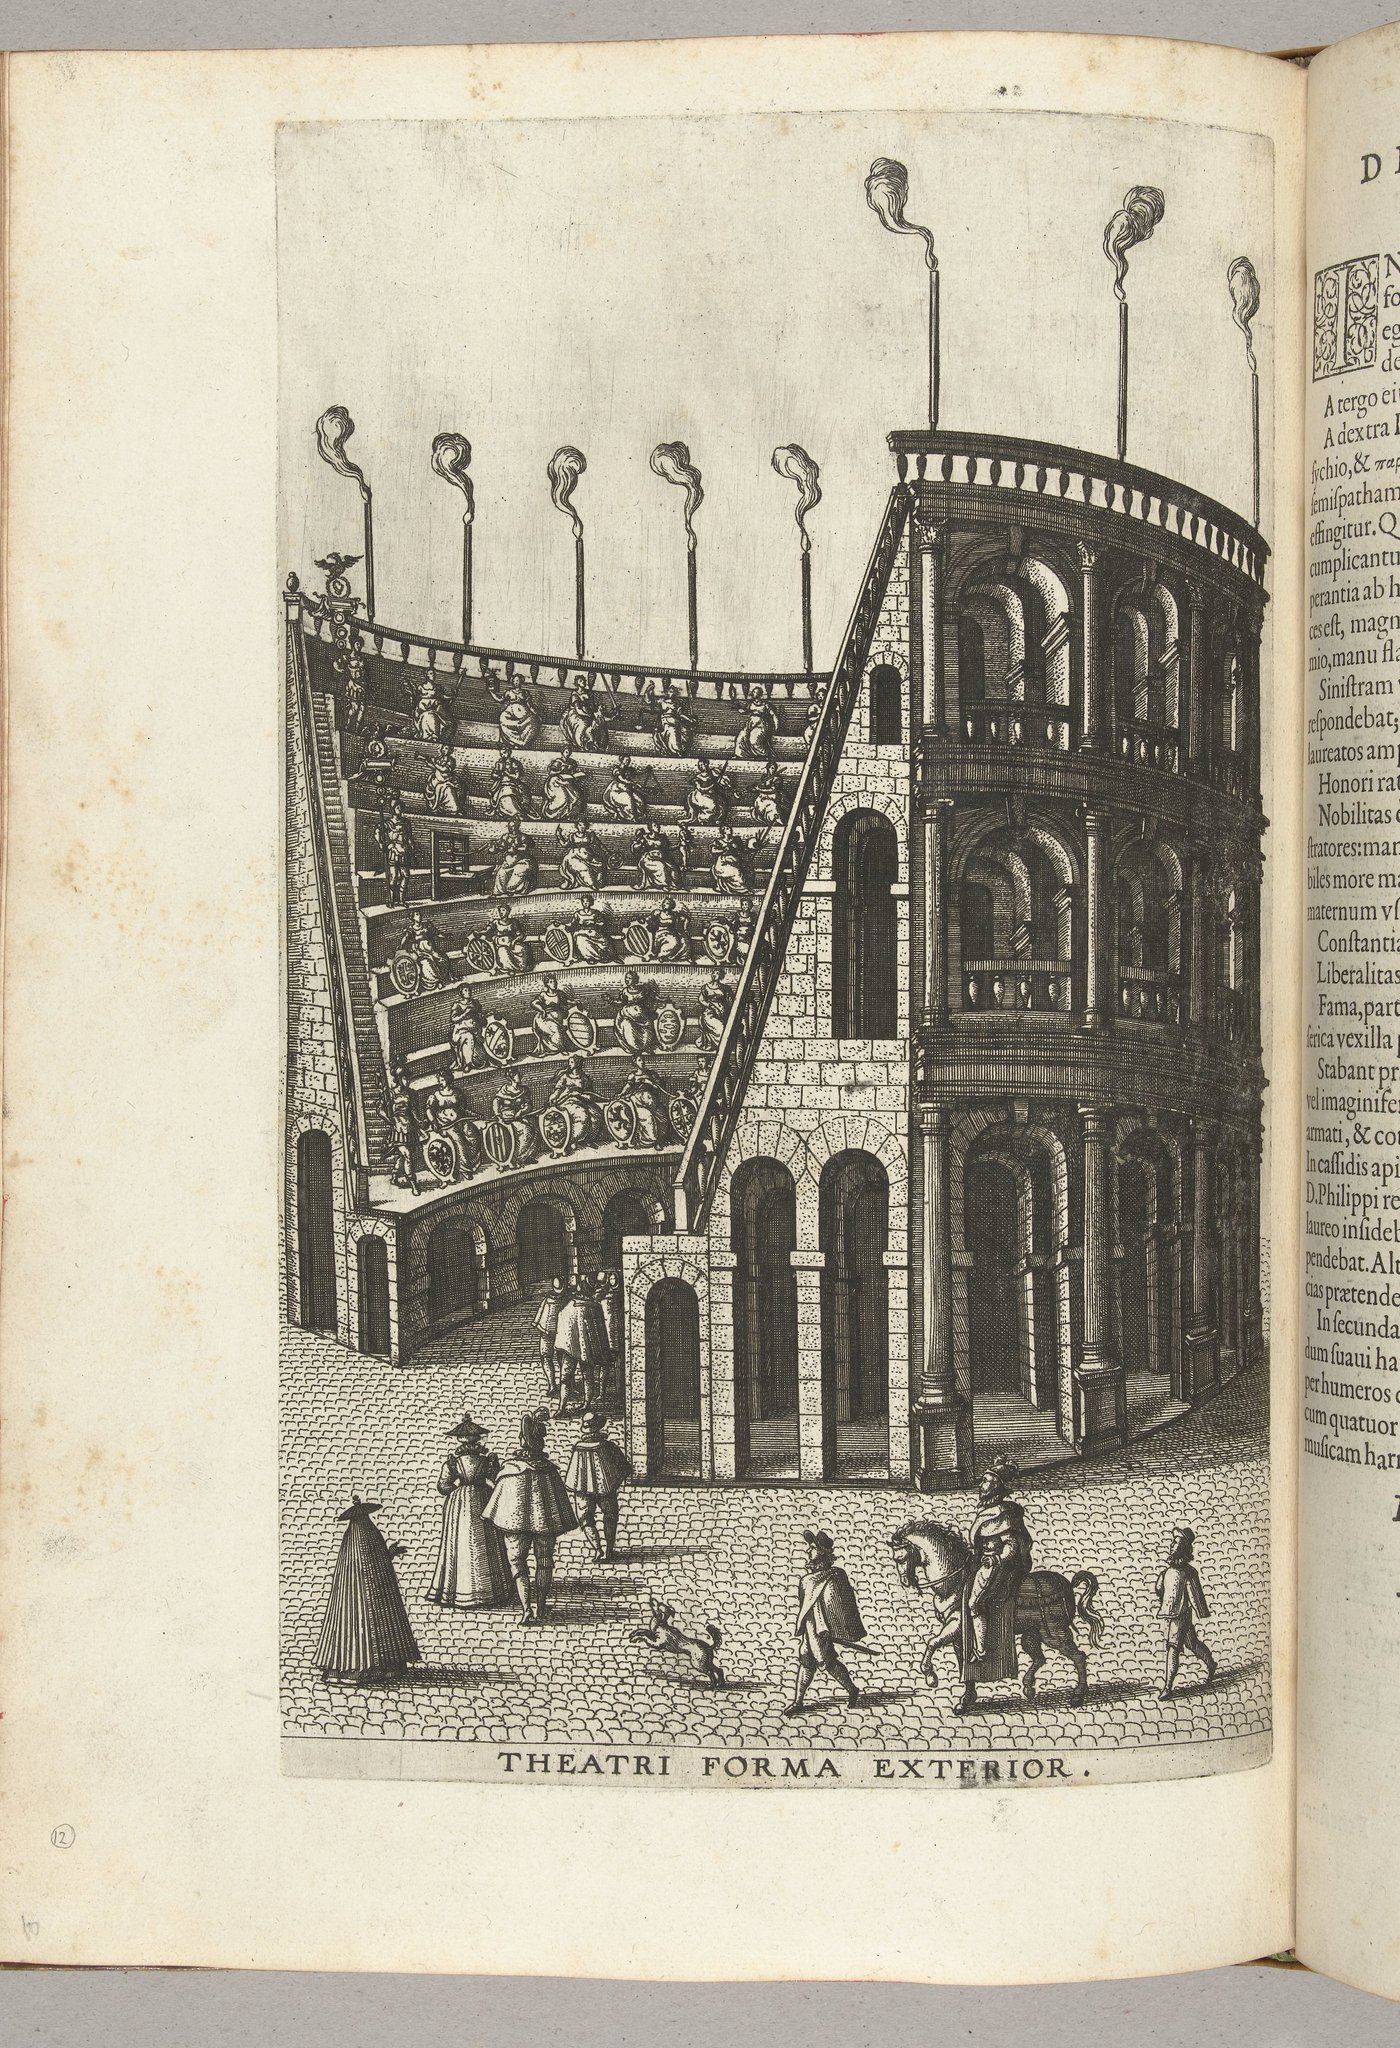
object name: print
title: Theatri Forma Exterior.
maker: pieter van der borcht (i)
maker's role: print maker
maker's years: 1545-1608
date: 1594-1595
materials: paper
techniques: etching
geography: antwerp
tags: brussels, triumphal entry and public reception, pageant, 'entrée solennelle', 'joyeuse entrée', antwerp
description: Theater van de Vrede (exterieur), naar het Colosseum te Rome. Opgericht aan de Meir. Onderdeel van de beschrijving van de intocht van aartshertog Ernst te Antwerpen, 18 juli 1594, door Joannes Bochius, Descriptio publicae gratulationis, spectaculorum et ludorum, in adventu Sereniss. Principis Ernesti Archiducis Austriae, Ex Officina Plantiniana, Antwerpen 1595.